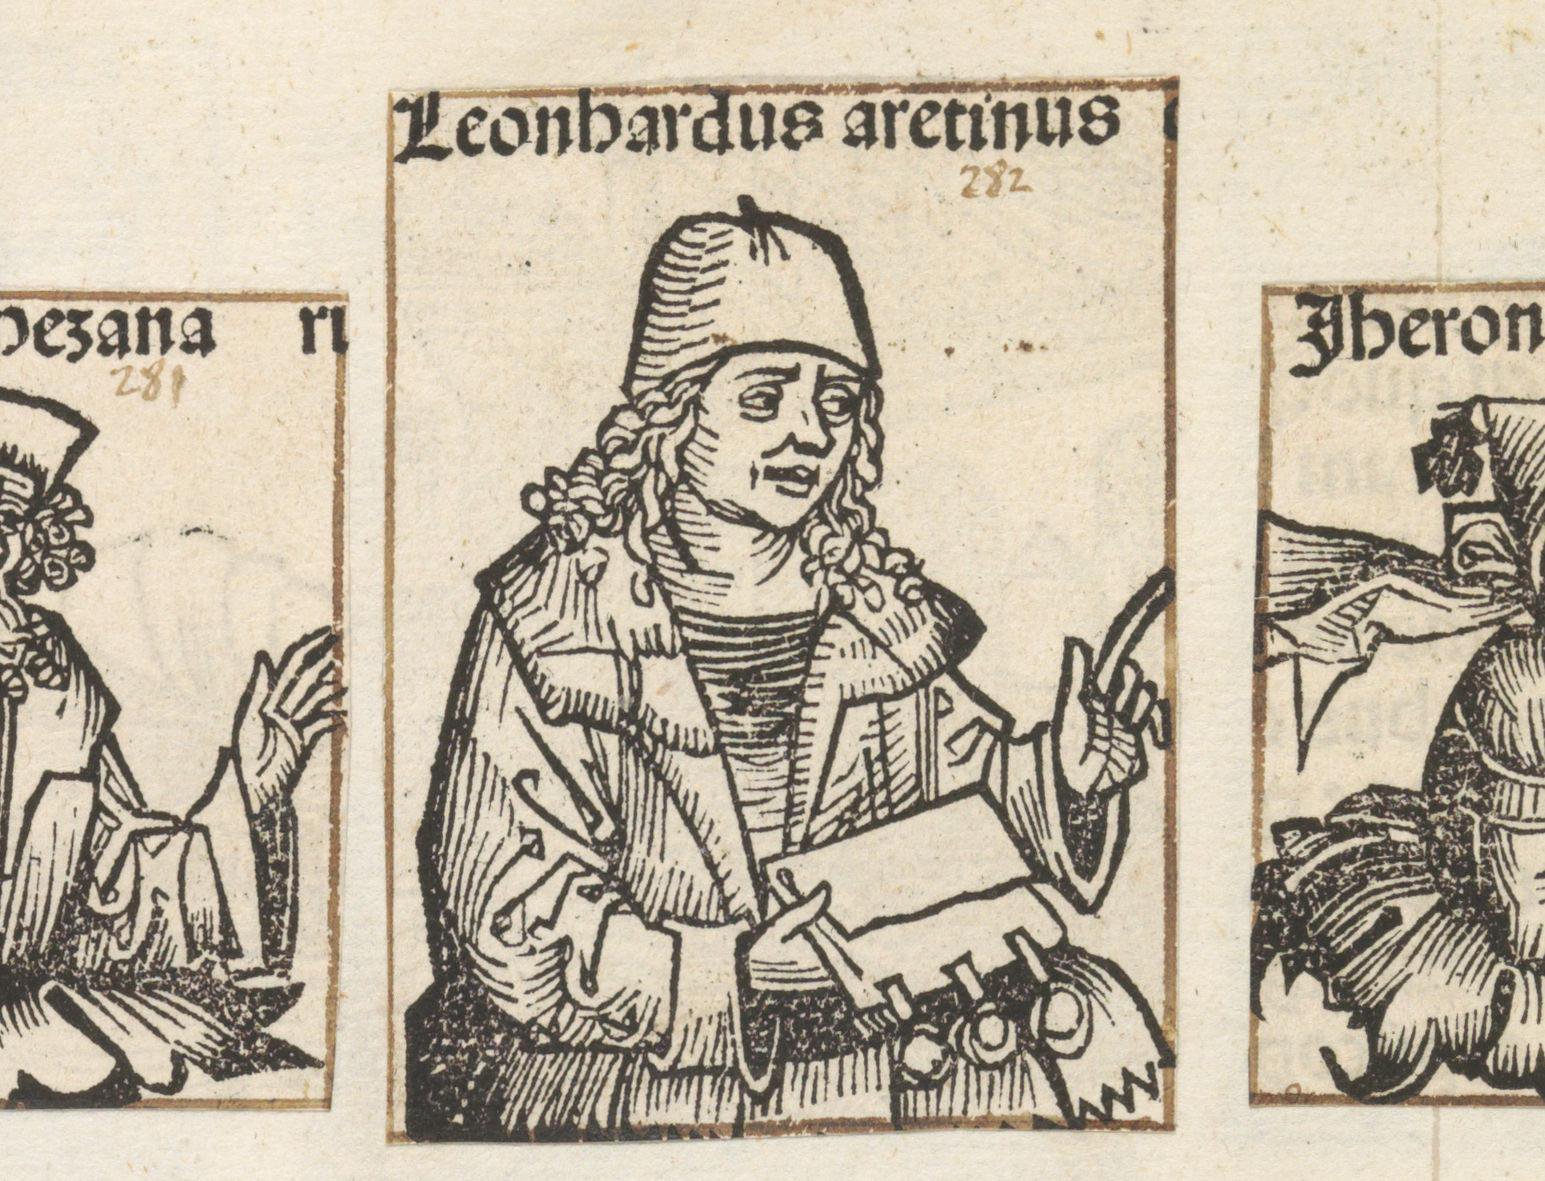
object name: album leaf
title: Leonhardus aretinus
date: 1493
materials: paper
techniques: letterpress printing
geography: nuremberg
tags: arezzo, florence, historicus, geleerde, leonardo bruni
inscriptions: inscription: ‘282’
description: De houtsnede wordt herhaaldelijk gebruikt als boekillustratie in de Liber Chronicarum (of Neurenbergkroniek) van Hartmann Schedel, verschenen in het Latijn en Duits in 1493. Zie de Latijnse uitgave, folio 241v.